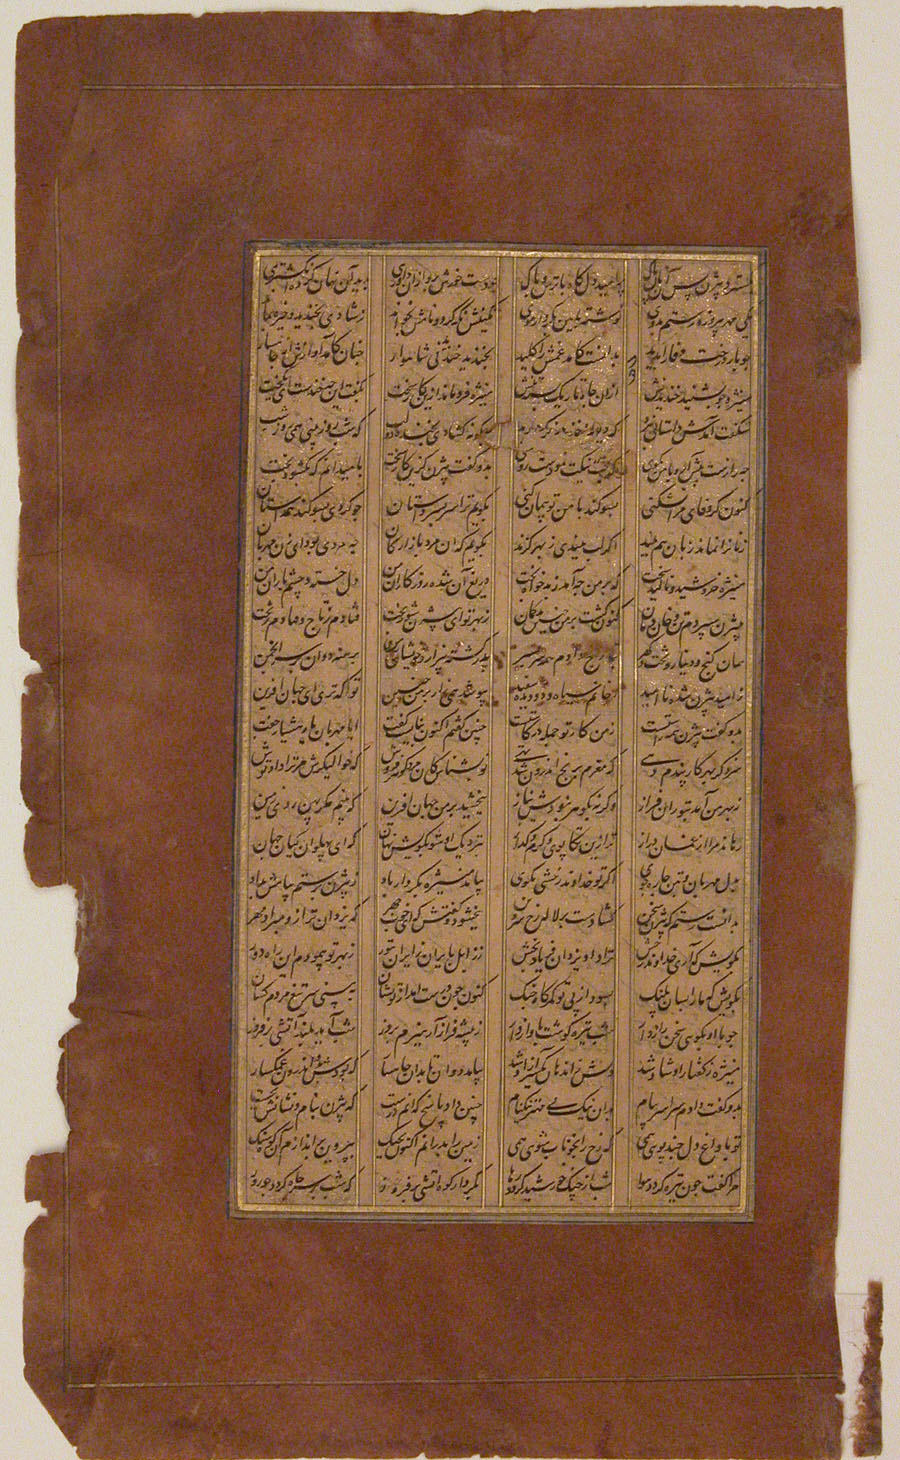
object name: folio from an illustrated manuscript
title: Page of Calligraphy from a Shahnama (Book of Kings)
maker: abu'l qasim firdausi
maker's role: author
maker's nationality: iranian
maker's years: 935-1020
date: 1610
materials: gold, ink, paper, watercolor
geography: india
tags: calligraphy